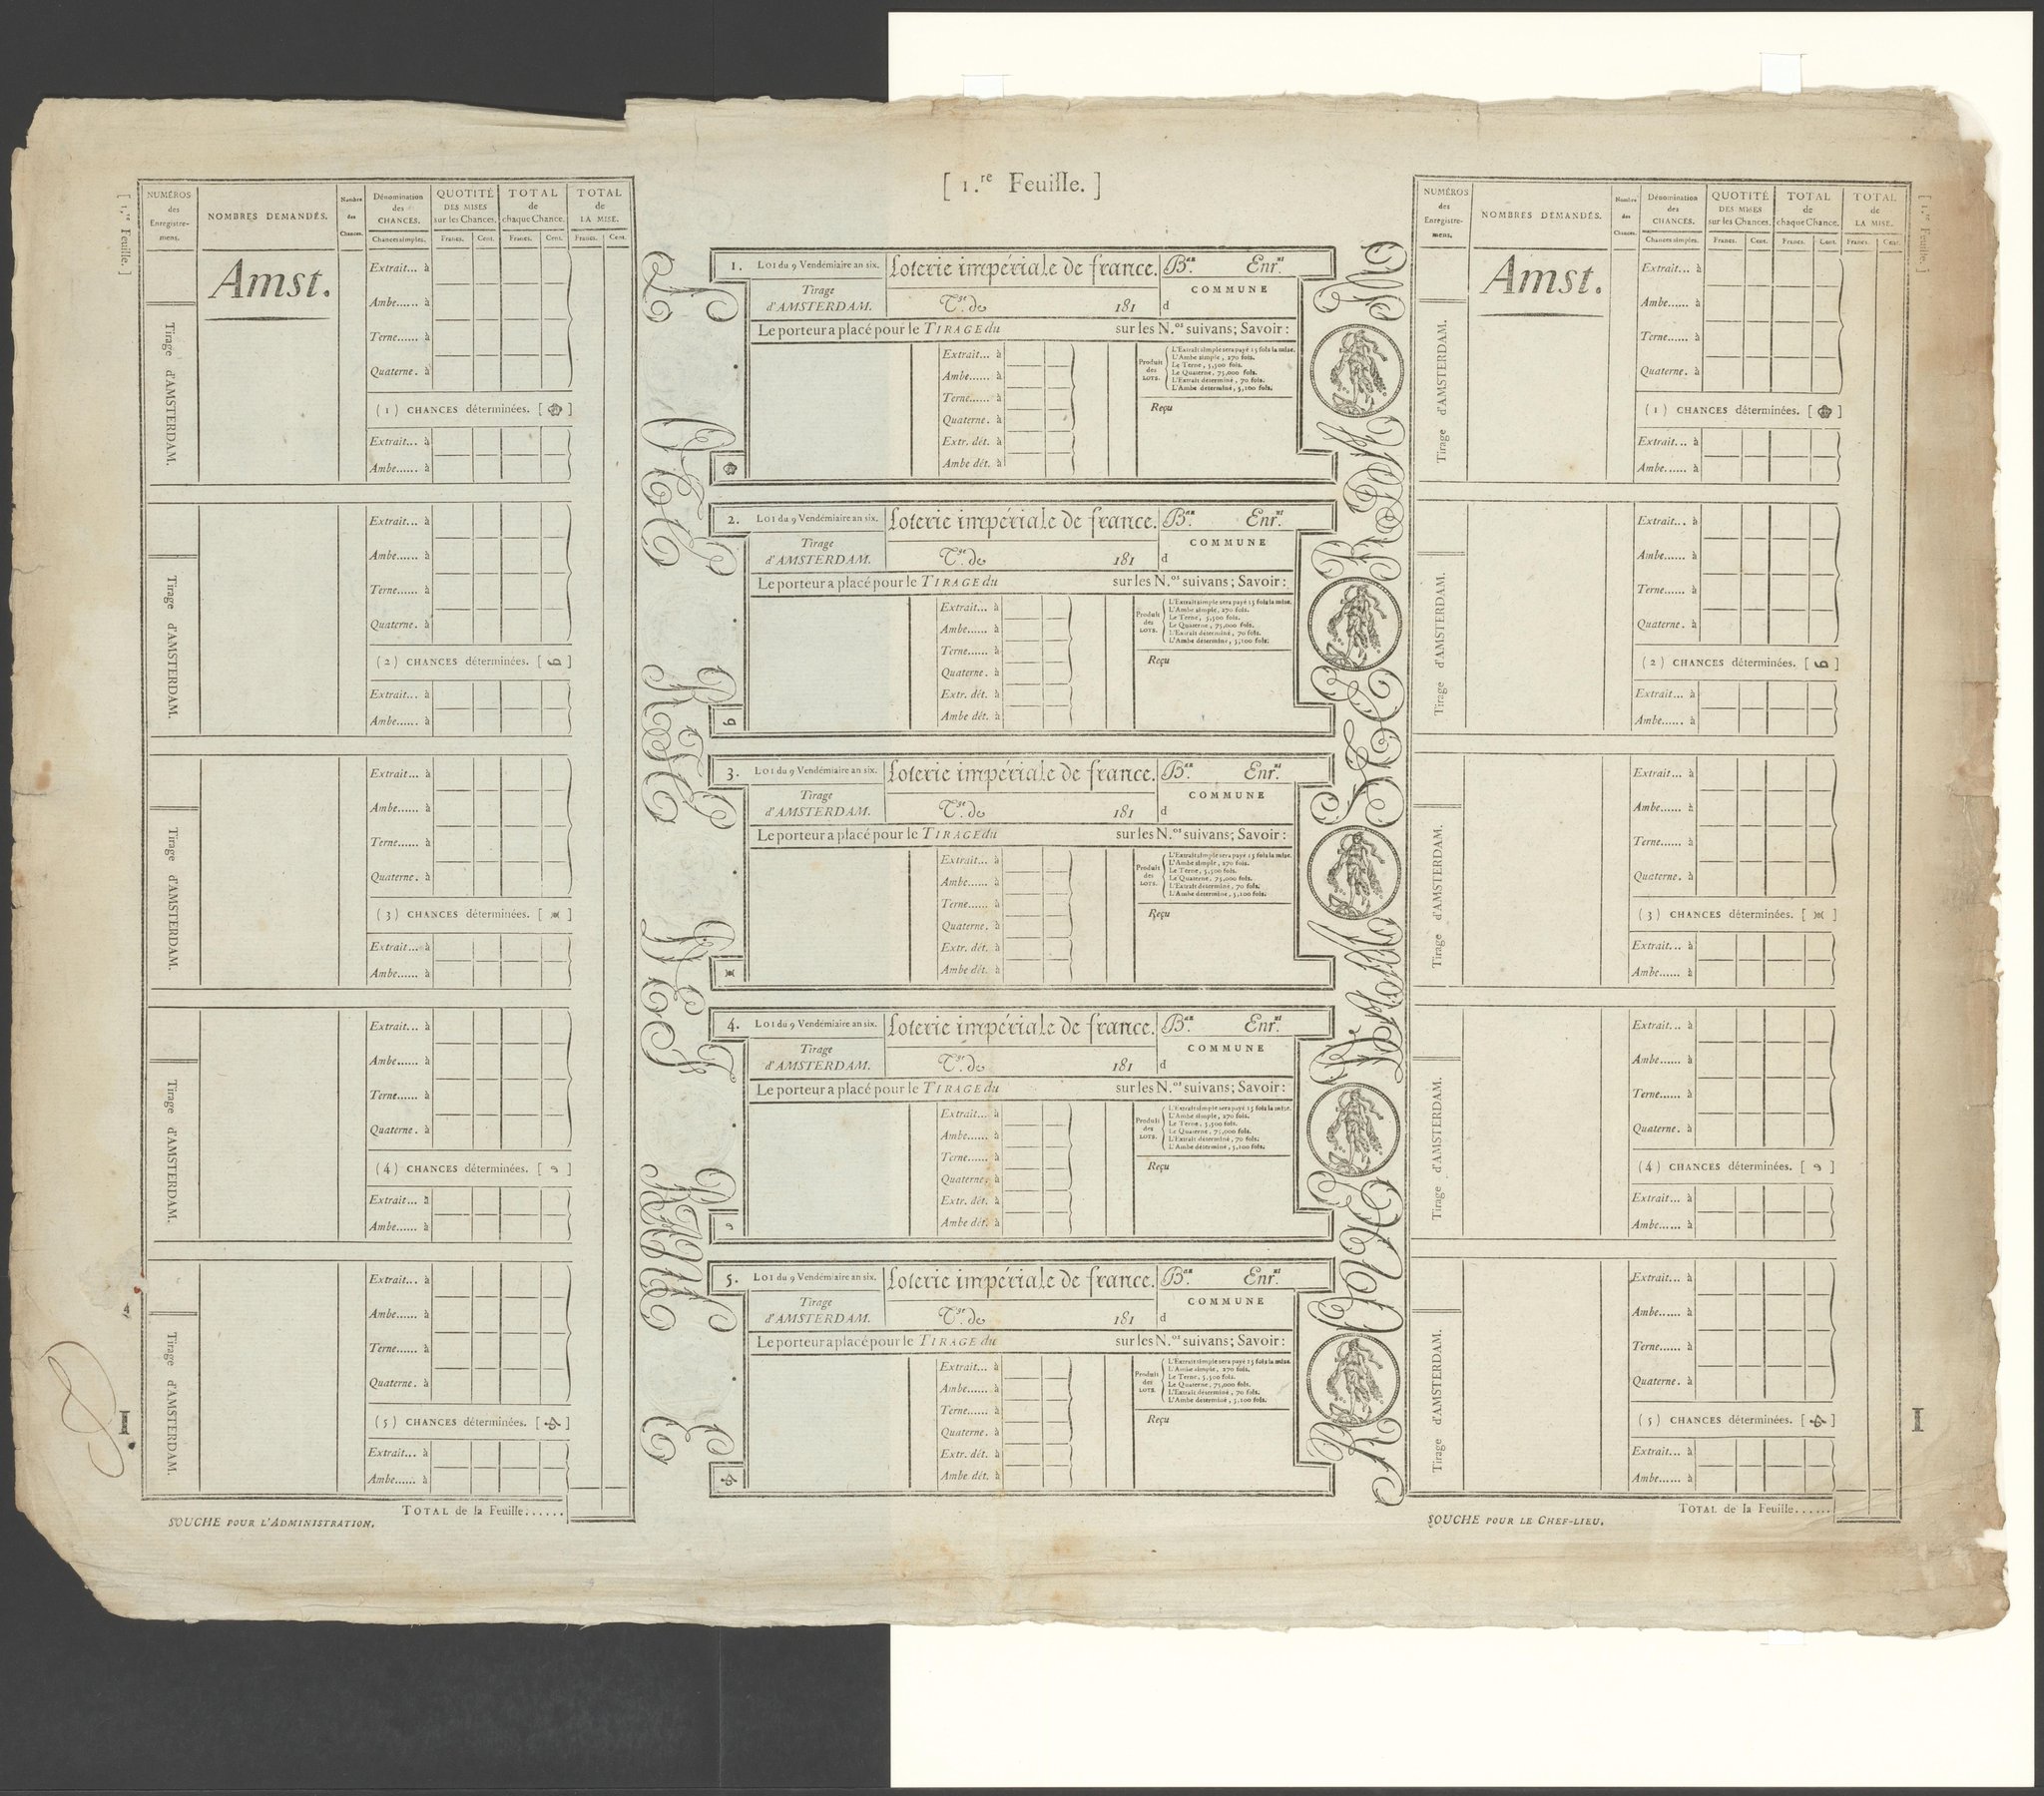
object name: text sheet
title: Onversneden blad met loterijbriefjes van de 'Loterie impériale de france' / 1.re Feuille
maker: Anonymous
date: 1810-1815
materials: paper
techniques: letterpress printing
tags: raffle, lottery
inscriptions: collector's mark, collector's mark: Lugt 1641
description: Onversneden blad met loterijbriefjes nrs. 1-5 voor de 'Tirage d'Amsterdam' van de van de 'Loterie impériale de france'. Blad genummerd bovenaan '1e Feuille'. Zoals vastgelegd bij de wet in Vendémiaire (jaar 1797-1798), met voorgedrukte trekkingsdatum 181... Onderwerpsrubrieken binnen de Atlas Zeden en Gewoonten: Spel en Vermaak; Loterij.